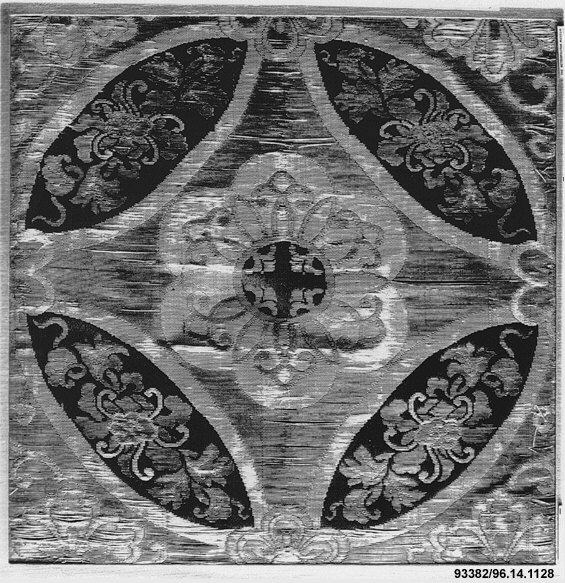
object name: piece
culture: japanese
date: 1701-1900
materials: silk